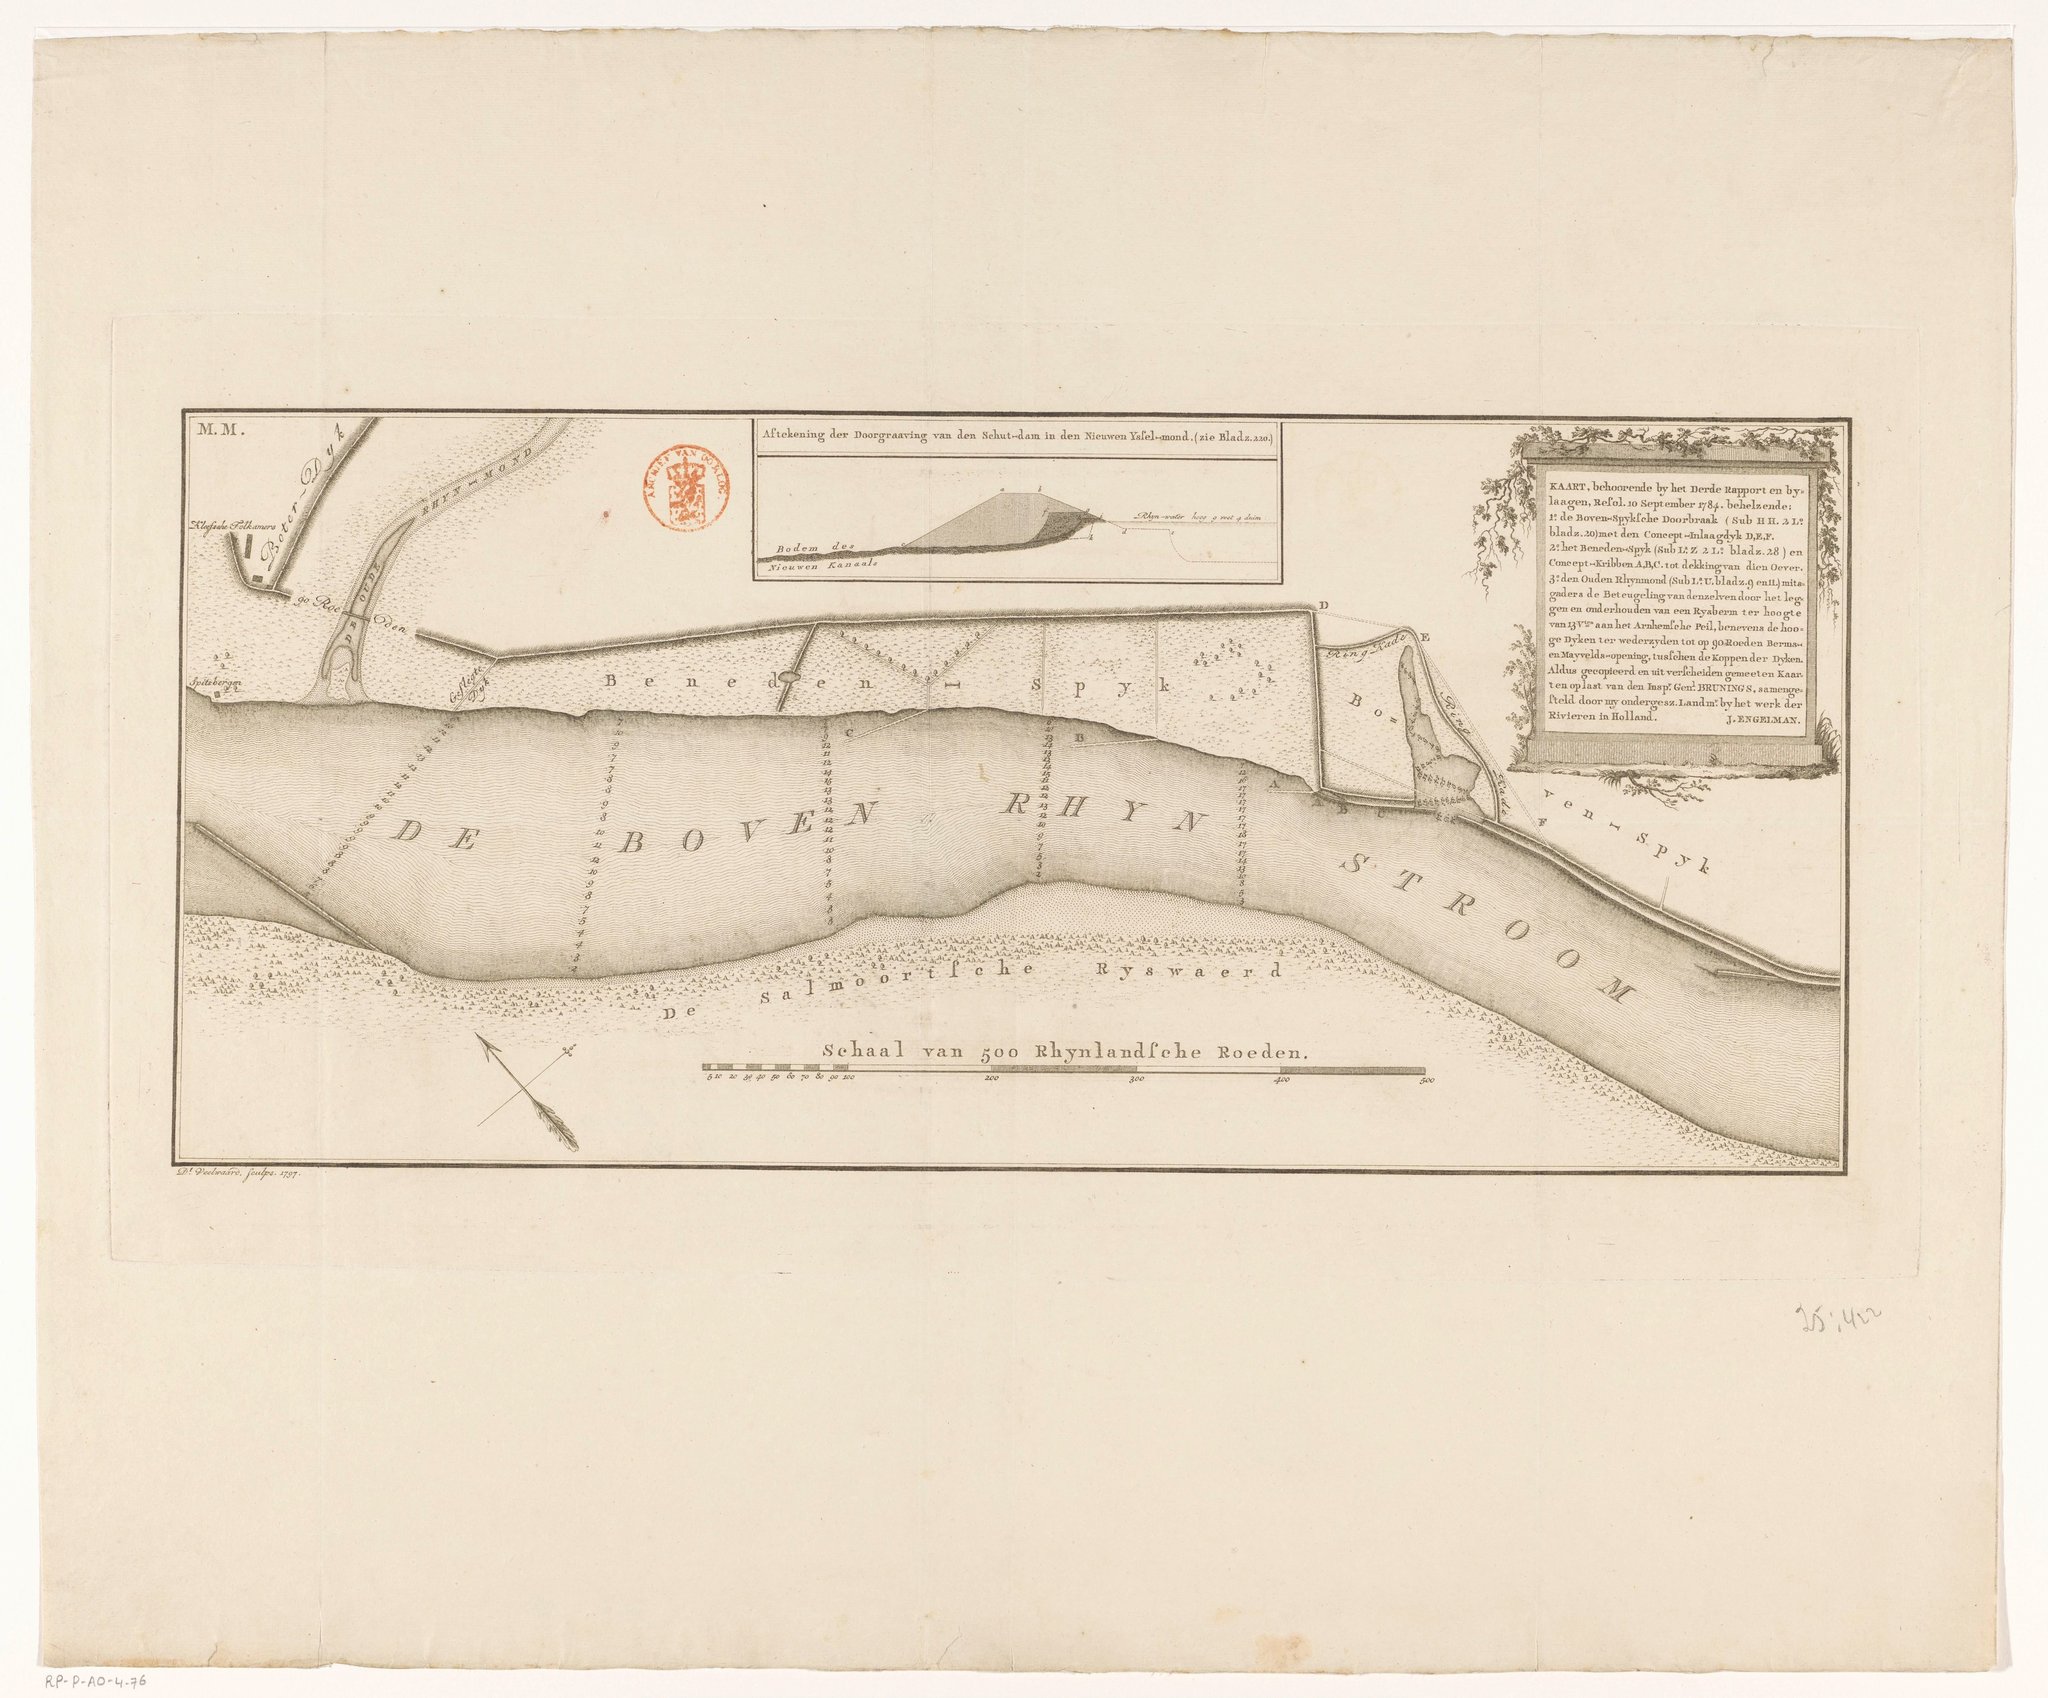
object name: map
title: Kaart, behoorende by het derde rapport en bylaagen, resol. 10 september 1784, behelzende: (...)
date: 1797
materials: paper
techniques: engraving, etching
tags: maps of separate countries or regions, river, gelderland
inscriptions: collector's mark: Lugt 19, collector's mark: Lugt 2228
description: Deze prent komt uit de atlas die hoort bij: Brunings, Christiaan. Verzameling van rapporten, verbaalen en verdere stukken, betreffende de doorsnydingen en werken, welken sedert de conventie in den jaare 1771 (…). 2 delen. Den Haag: ’s Lands Drukkery van Holland, 1798.